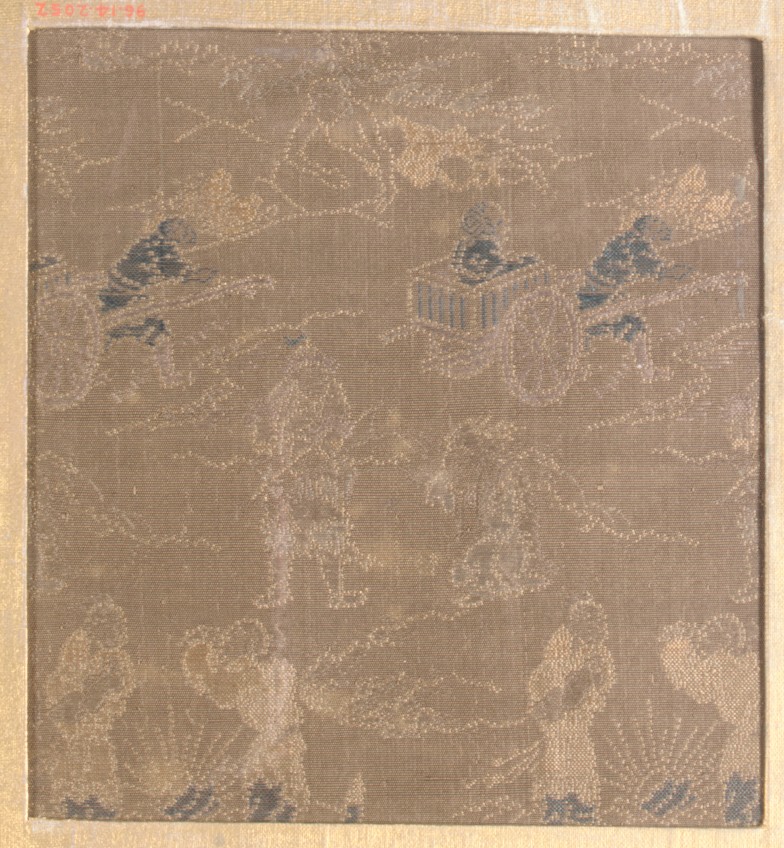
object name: piece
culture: japanese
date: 1701-1900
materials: silk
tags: men